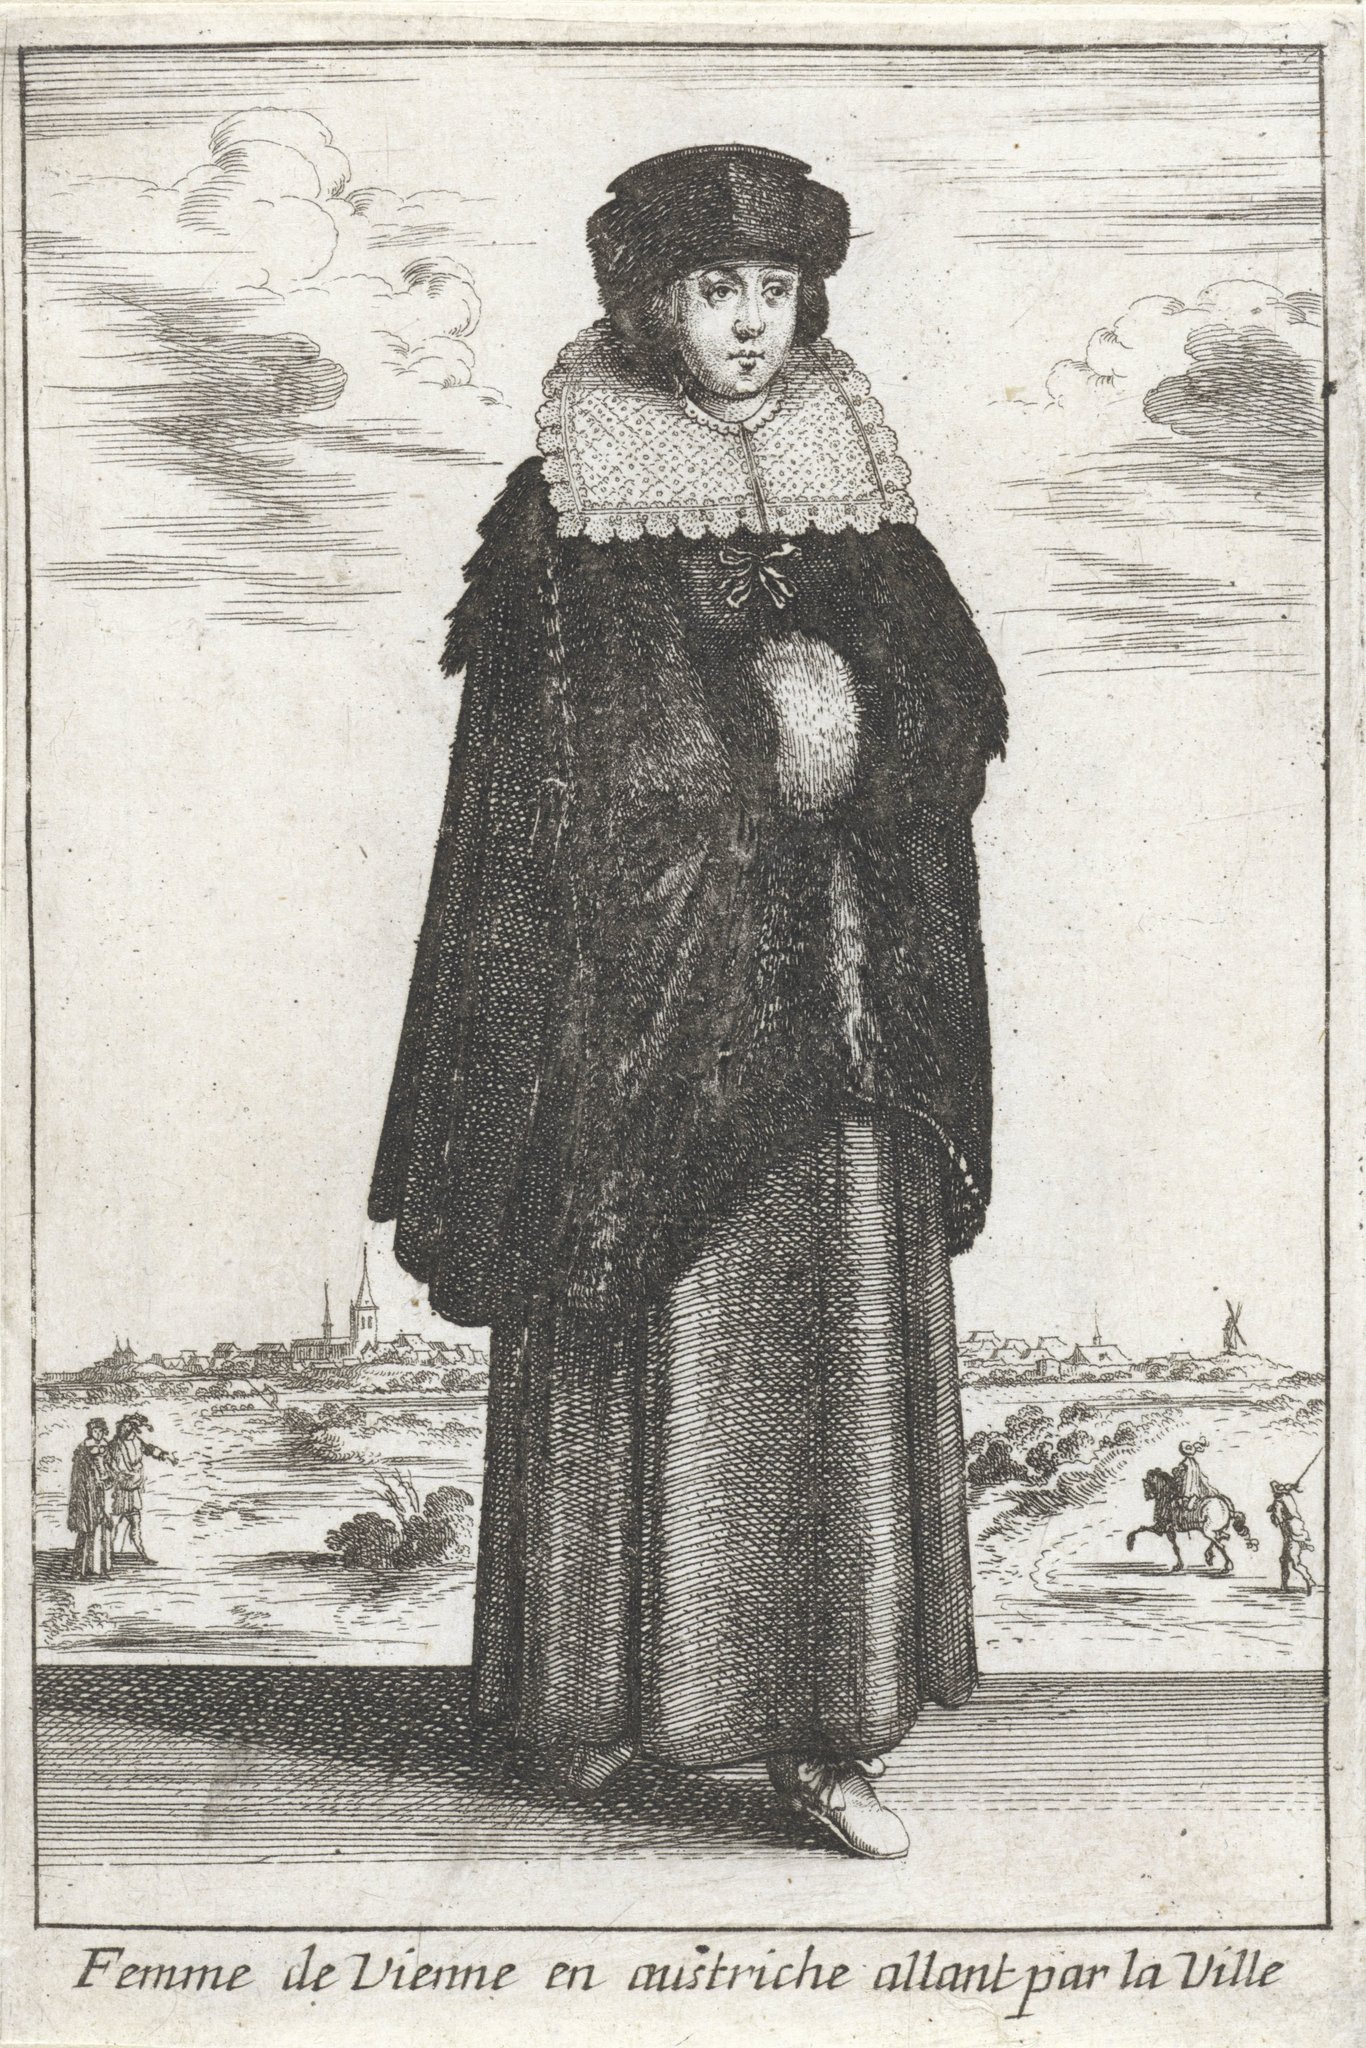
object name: costume print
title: Vrouwen in klederdracht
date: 1662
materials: paper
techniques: etching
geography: paris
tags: vienna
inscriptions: collector's mark: Lugt 240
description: Kopie naar prent die deel uitmaakt van de 50-delige serie met Europese klederdrachten, getiteld "Aula Veneris".. De prent maakt deel uit van de 28-delige serie (excl. titelprent) met voorstellingen van vrouwen in verschillende klederdrachten, getiteld "Livre curieux contenant la naifue representations des habits des femmes des diverses parties du Monde (...), 1662".